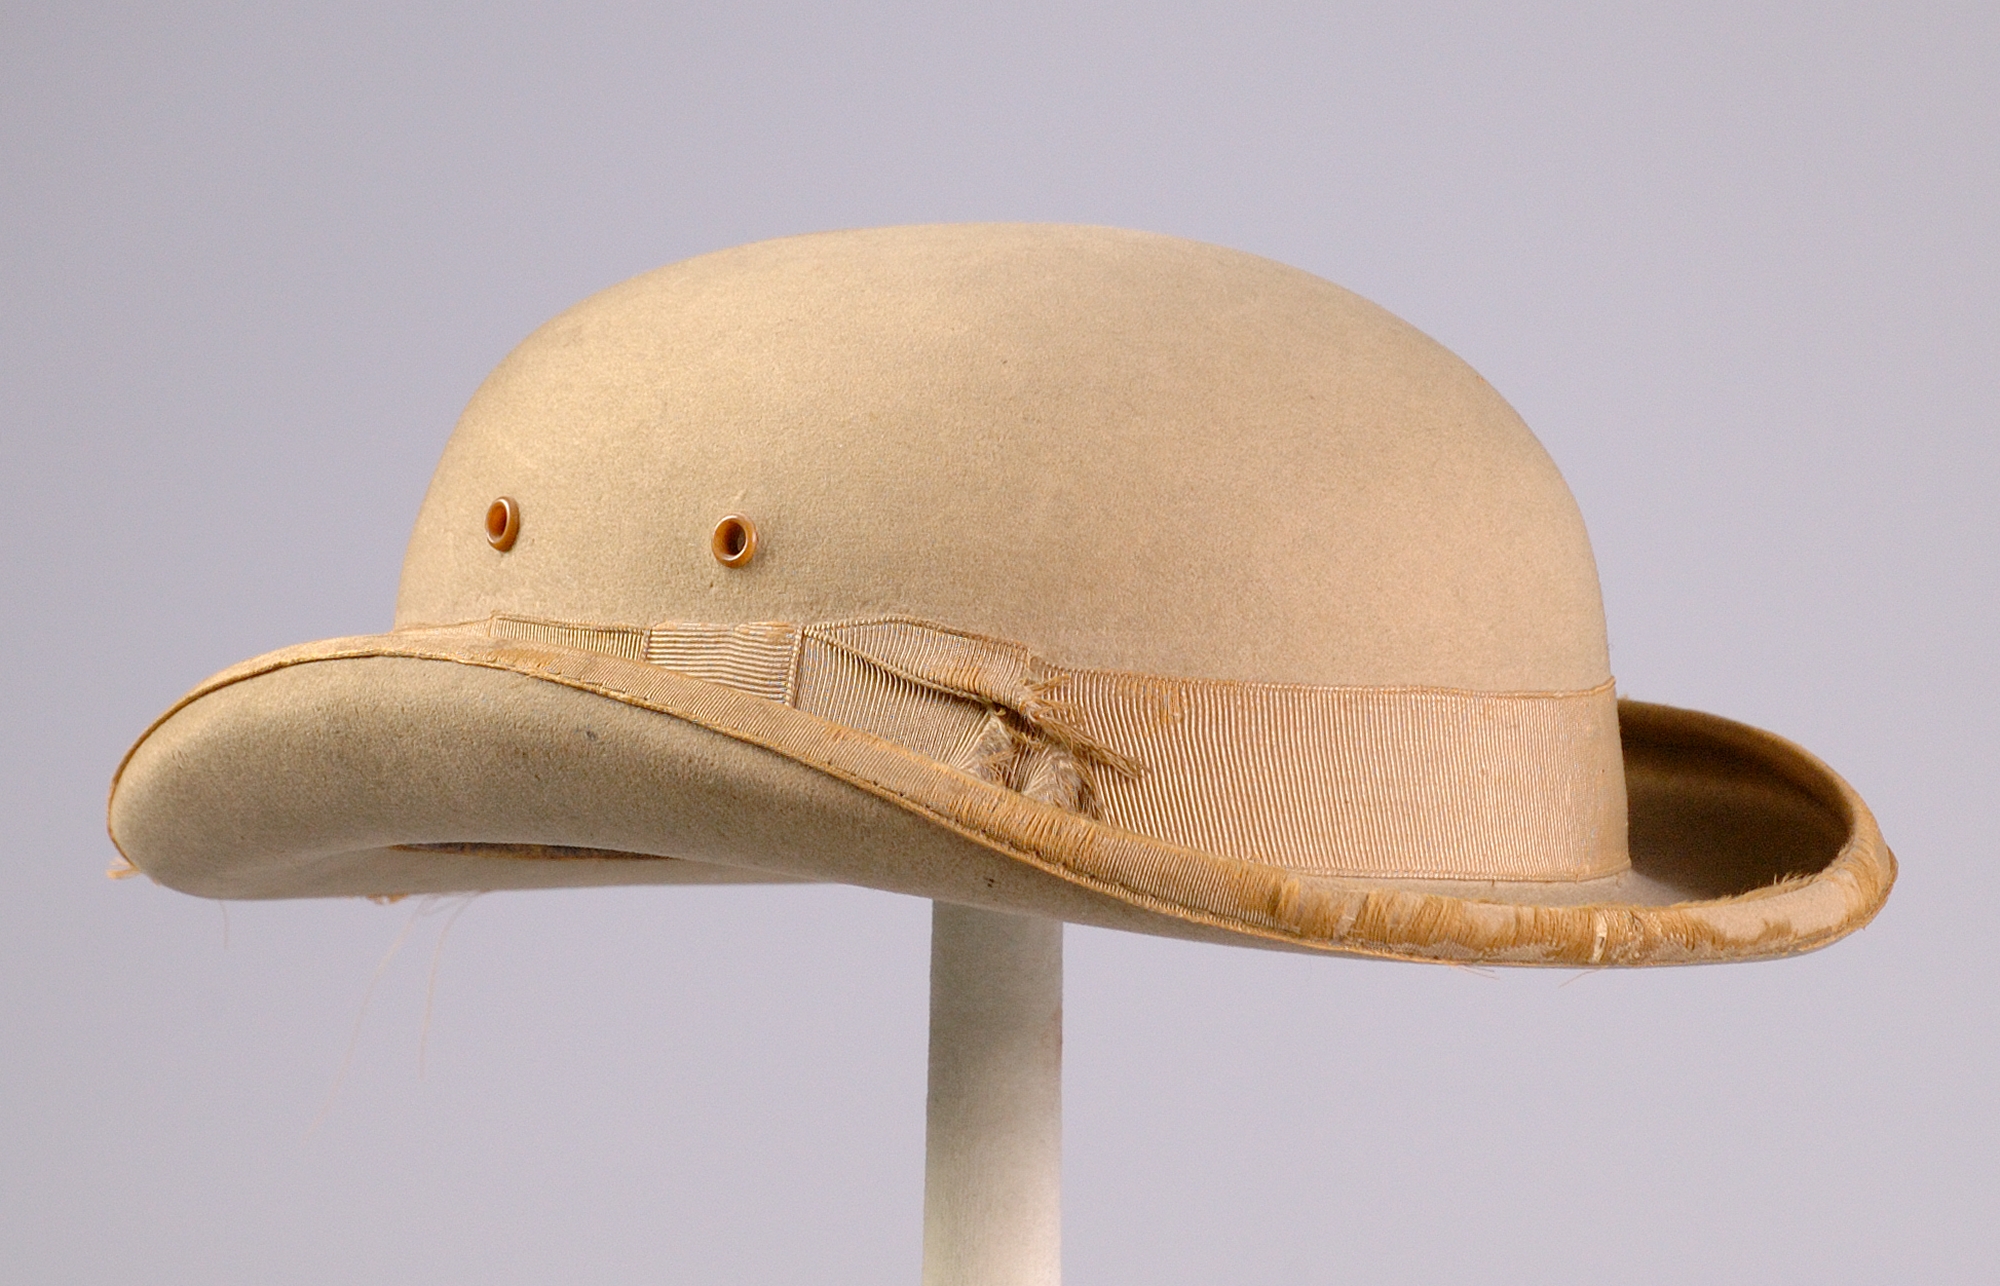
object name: derby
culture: british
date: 1865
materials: silk, wool